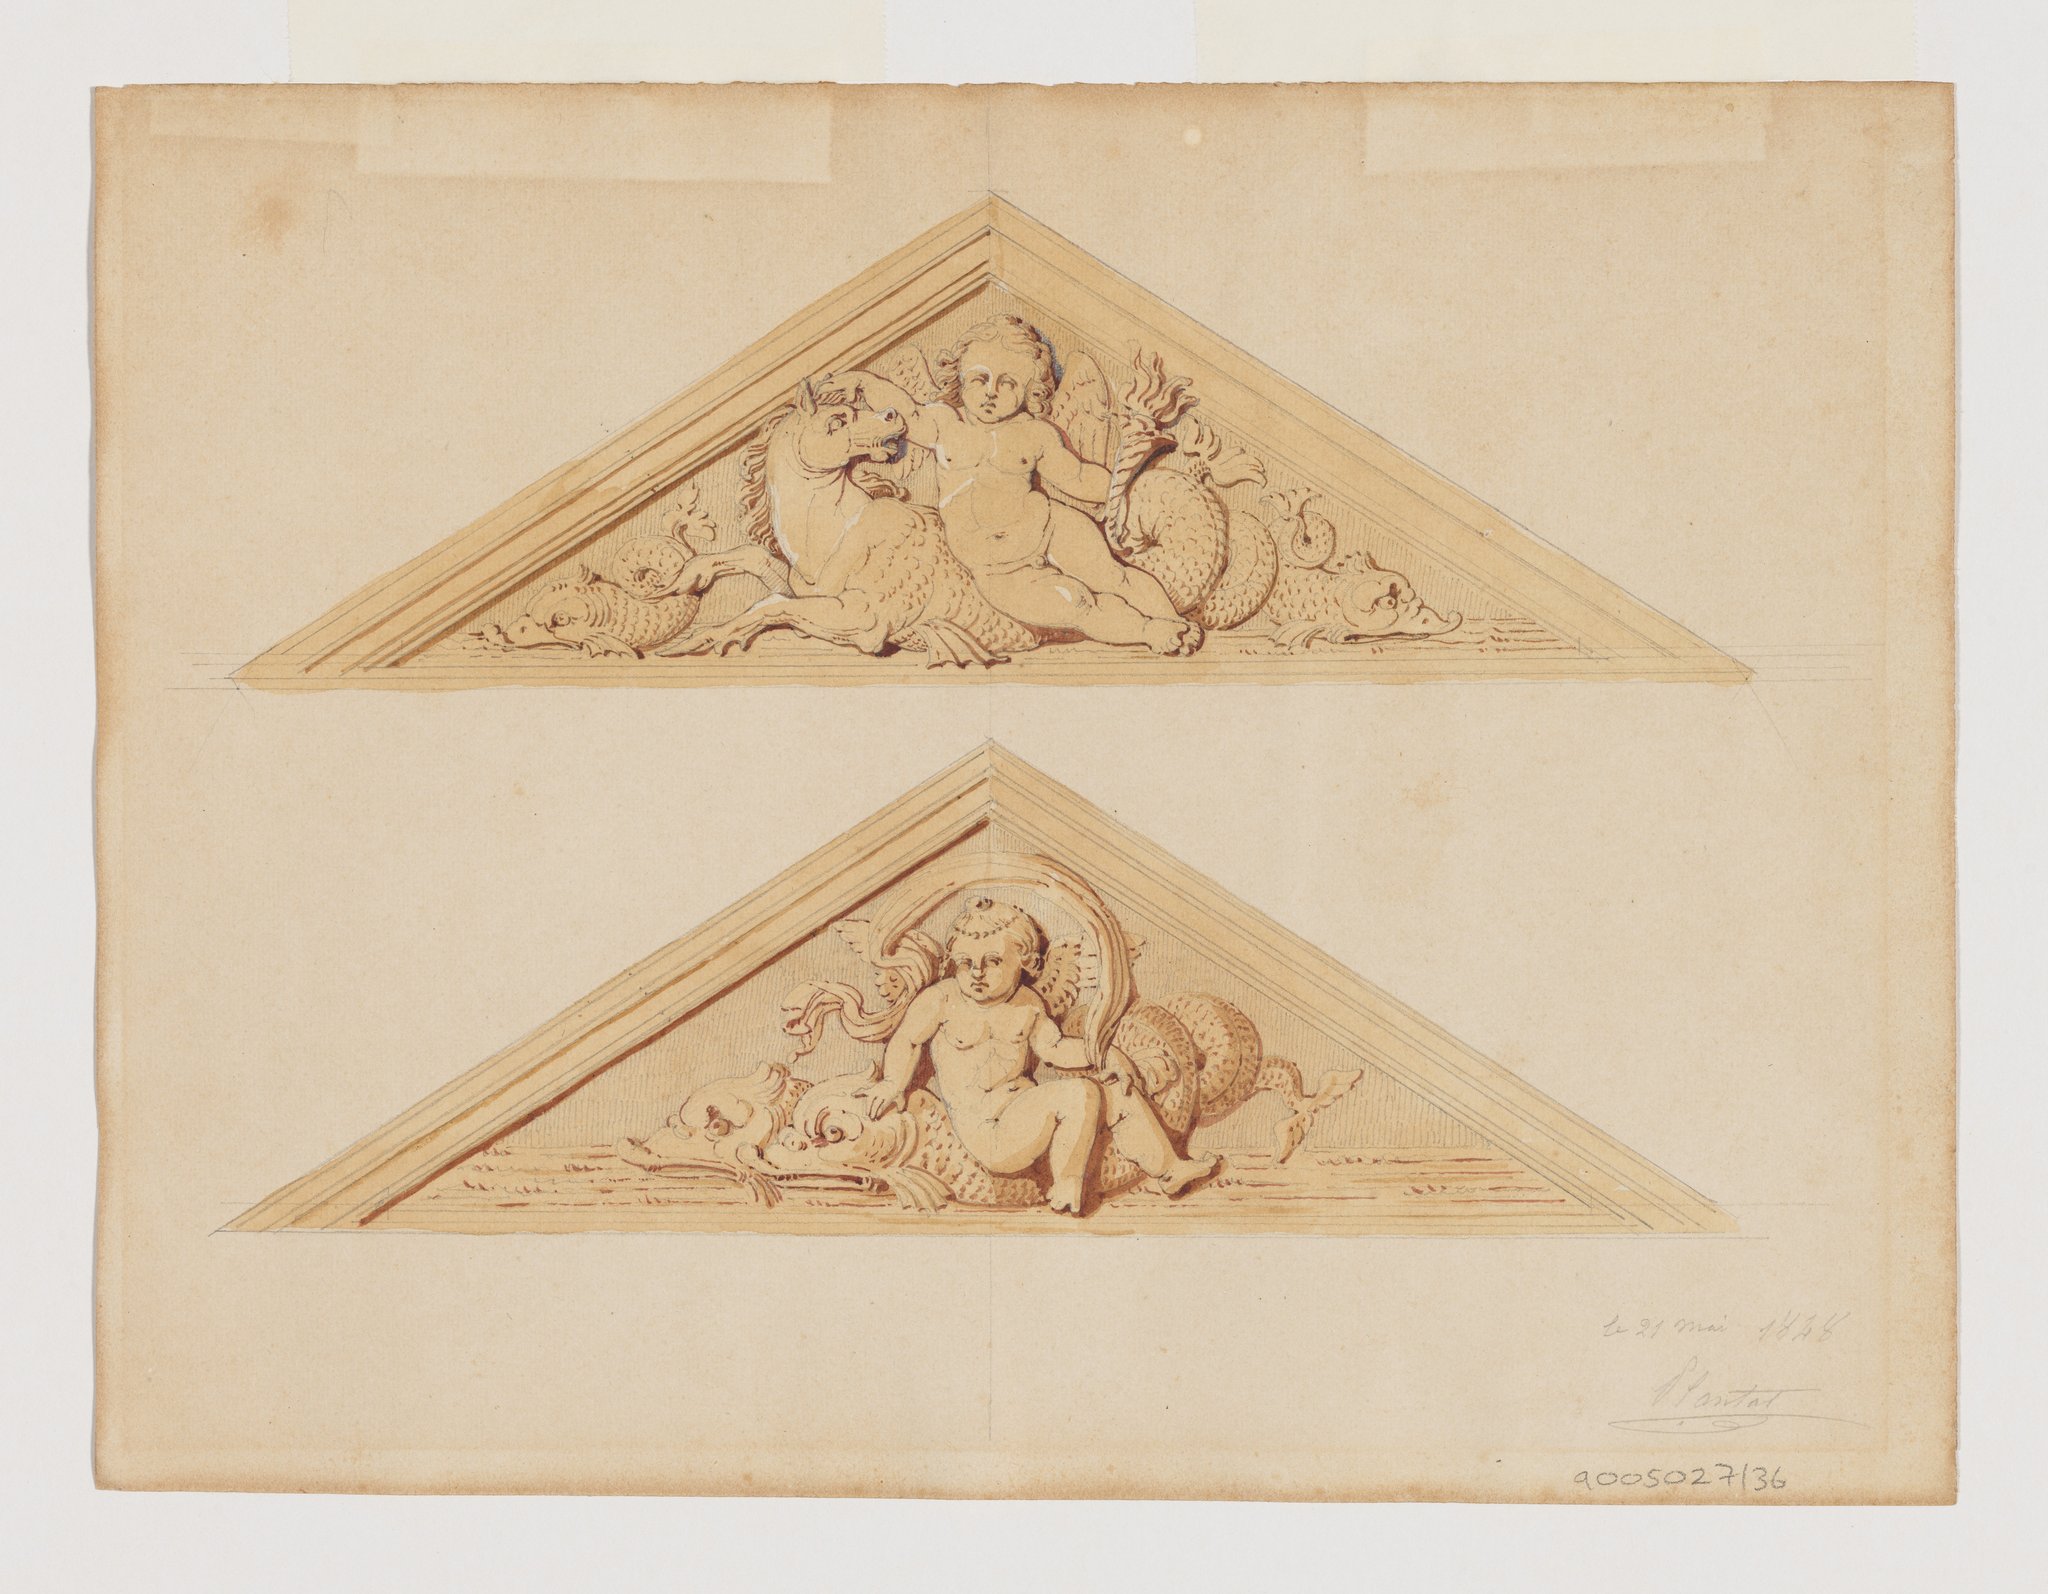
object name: drawing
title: Two Designs for Pediments with Putti and Sea Creatures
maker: jean-baptiste louis plantar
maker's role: artist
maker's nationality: french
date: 1834-1866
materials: graphite, ink, watercolor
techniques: pen